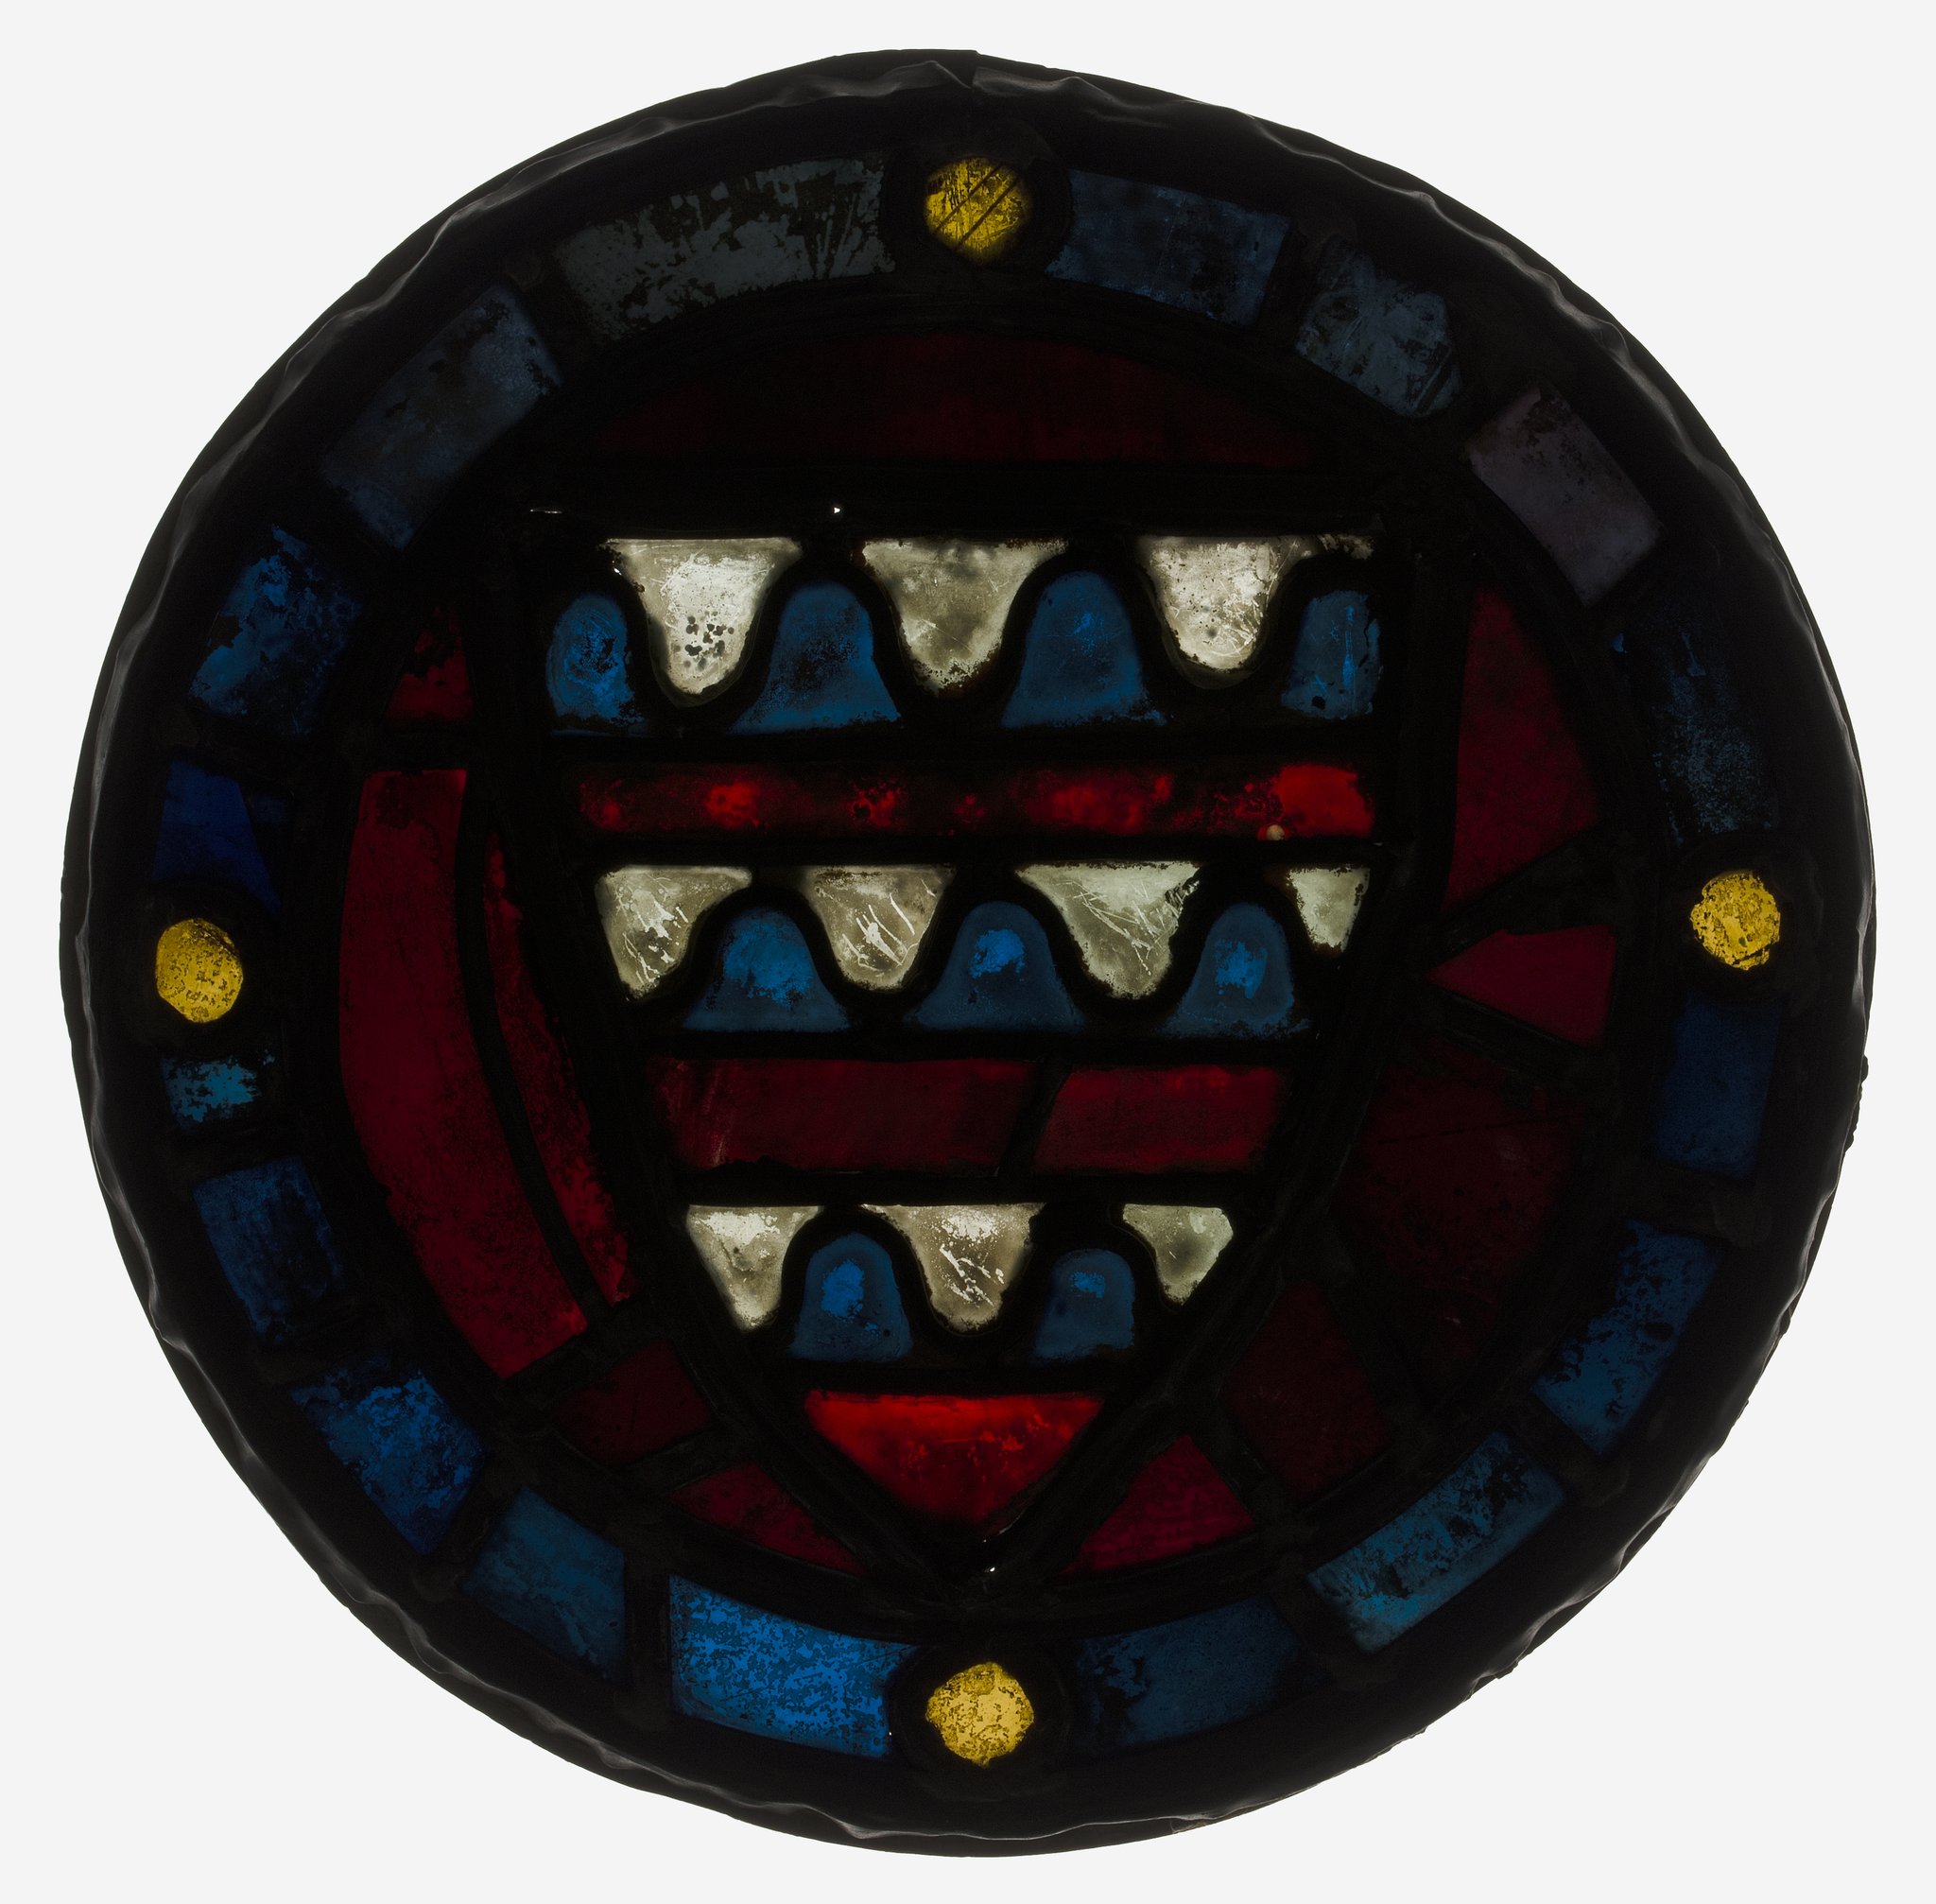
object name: roundel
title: Roundel with the Arms of Coucy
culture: british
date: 1360-1377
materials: glass, metal, paint